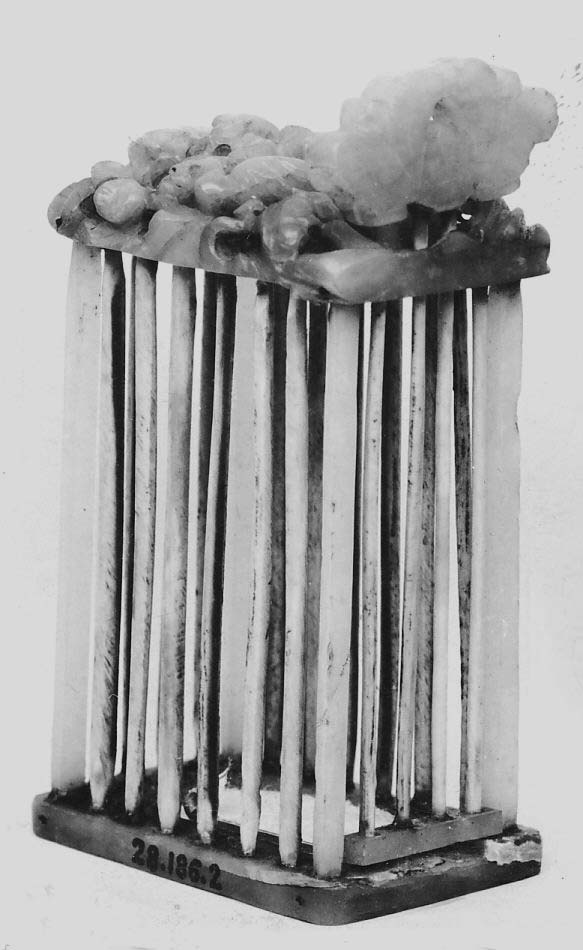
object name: cricket trap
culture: chinese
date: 1701-1900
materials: ivory, jade